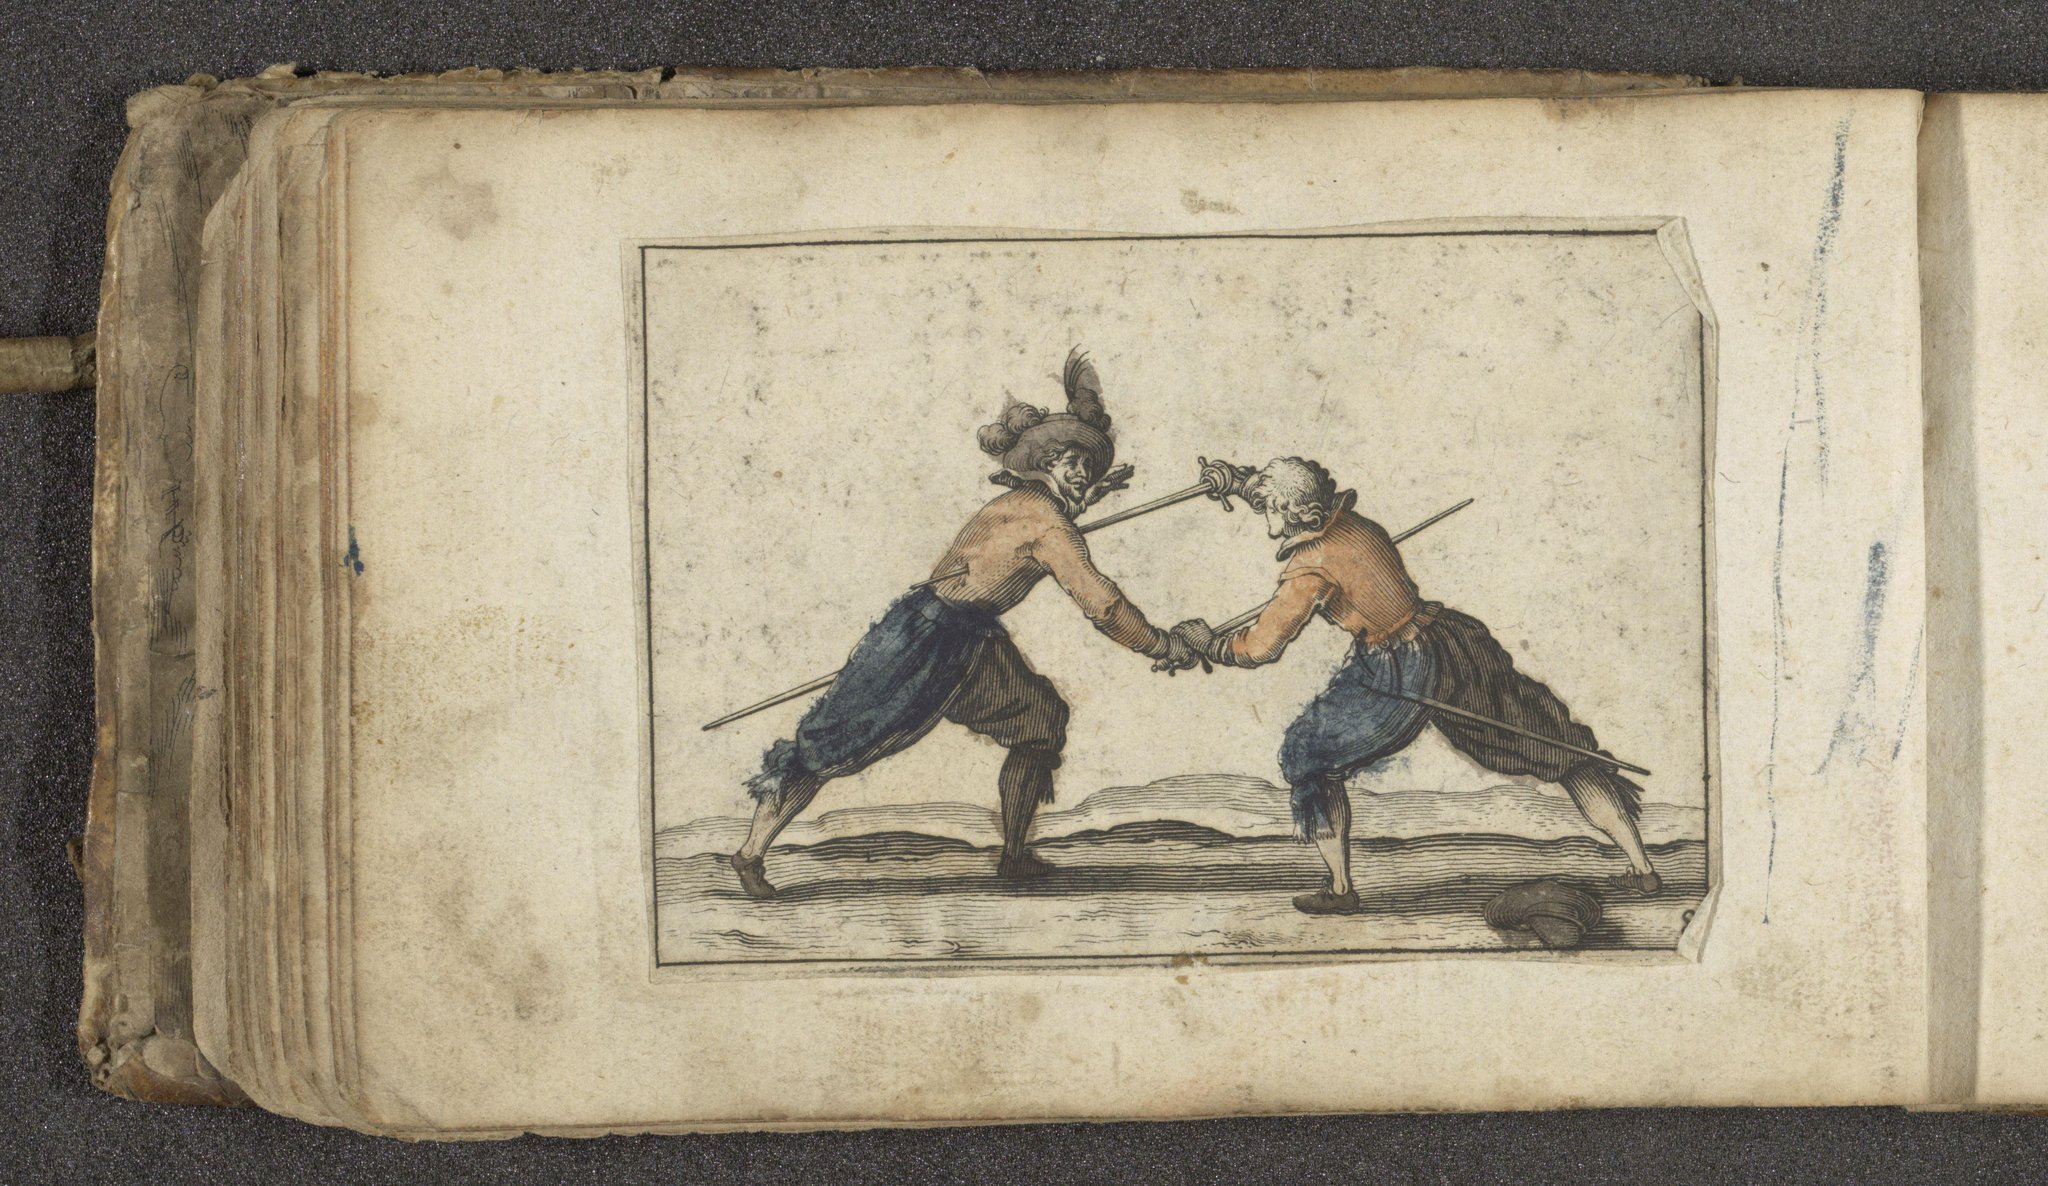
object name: album leaf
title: Ein Newes Reissbüchlein für die Jugent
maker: paul göttich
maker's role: graveur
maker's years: 1586-1622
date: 1621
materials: paper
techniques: colour, engraving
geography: augsburg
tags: actor (on the stage), head-gear: hat (+ feathers used for clothes)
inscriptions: inscription: ‘53’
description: Twee heren of acteurs bevechten elkaar met sabels. De linker man doorboort de rechter. De prent maakt deel uit van een album.